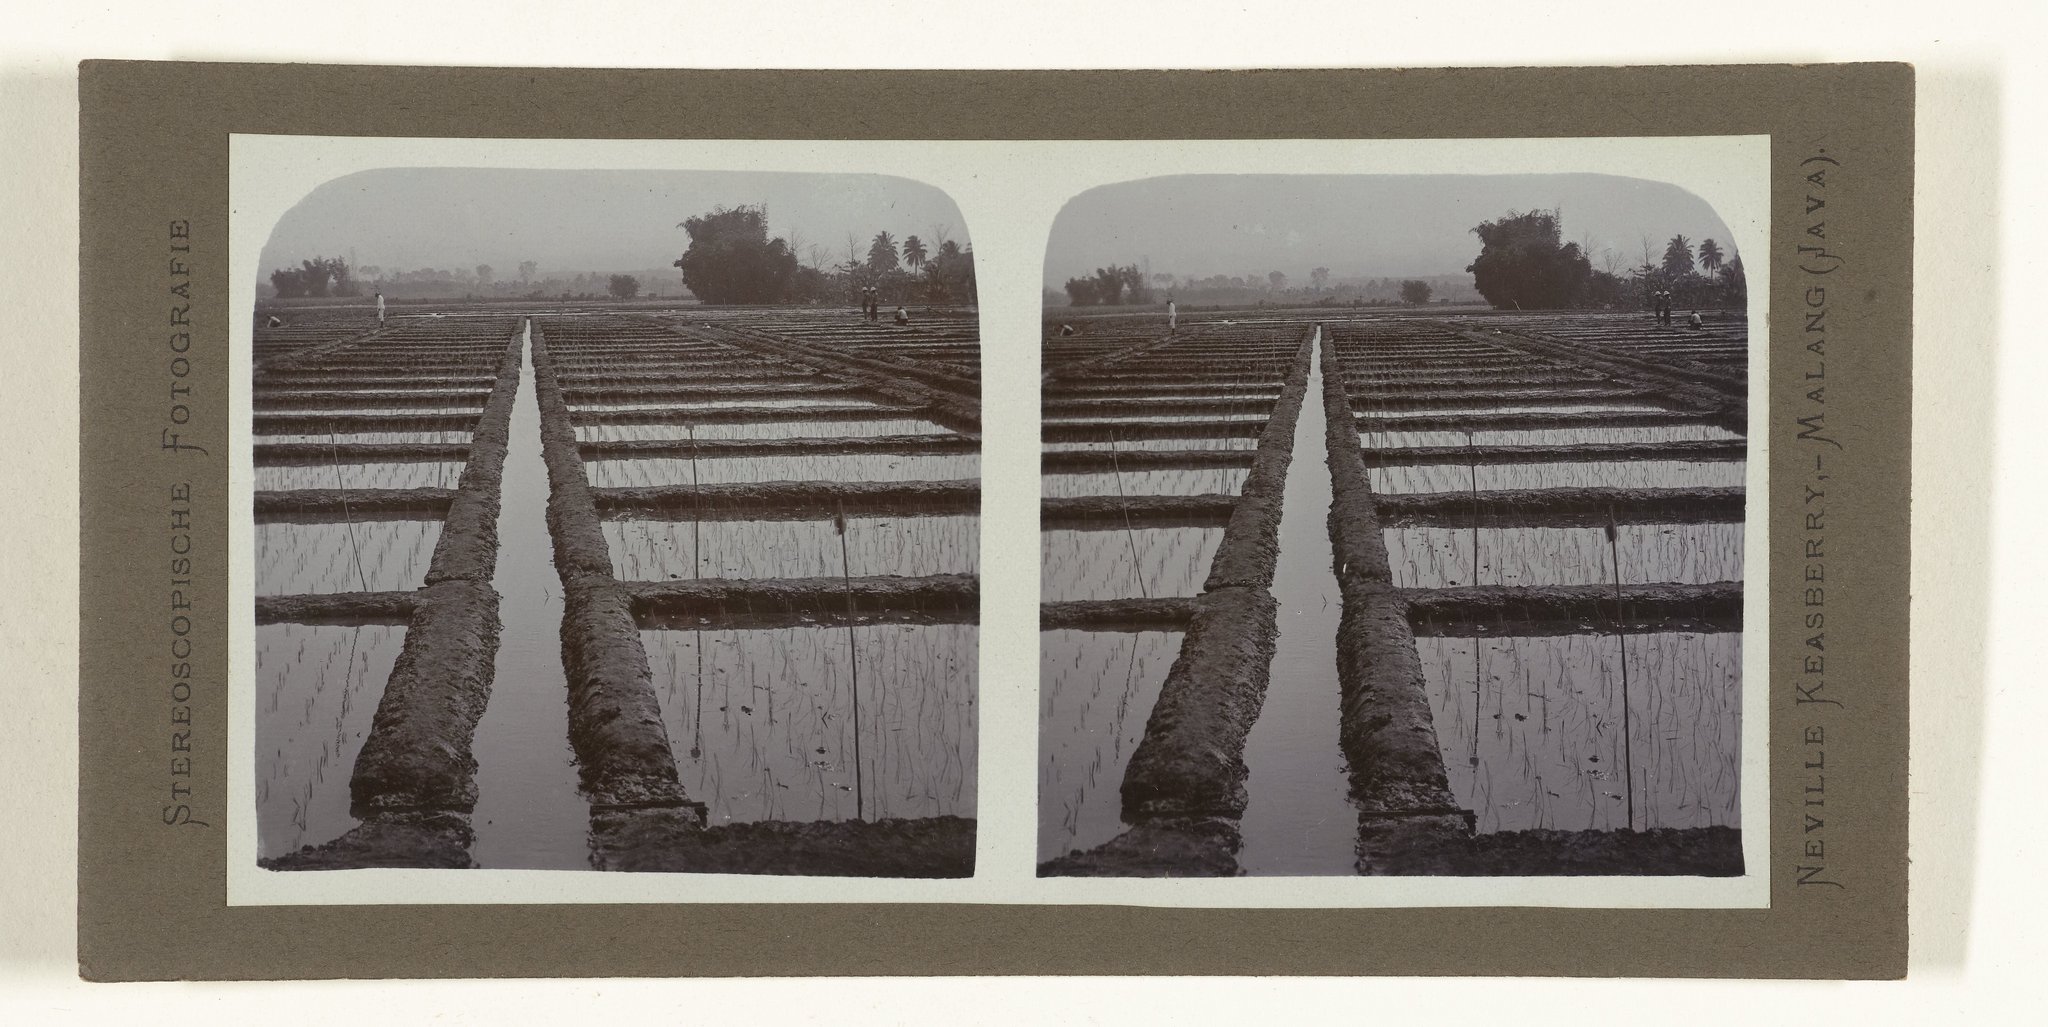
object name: stereograph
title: Gezicht op een sawah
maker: neville keasberry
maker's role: fotograaf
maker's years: 1866-1944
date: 1900-1935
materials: cardboard, paper, photographic support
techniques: albumen print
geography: malang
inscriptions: signature: ‘Neville Keasberry, Malang (Java)’, inscription: ‘Stereoscopische Fotografie’